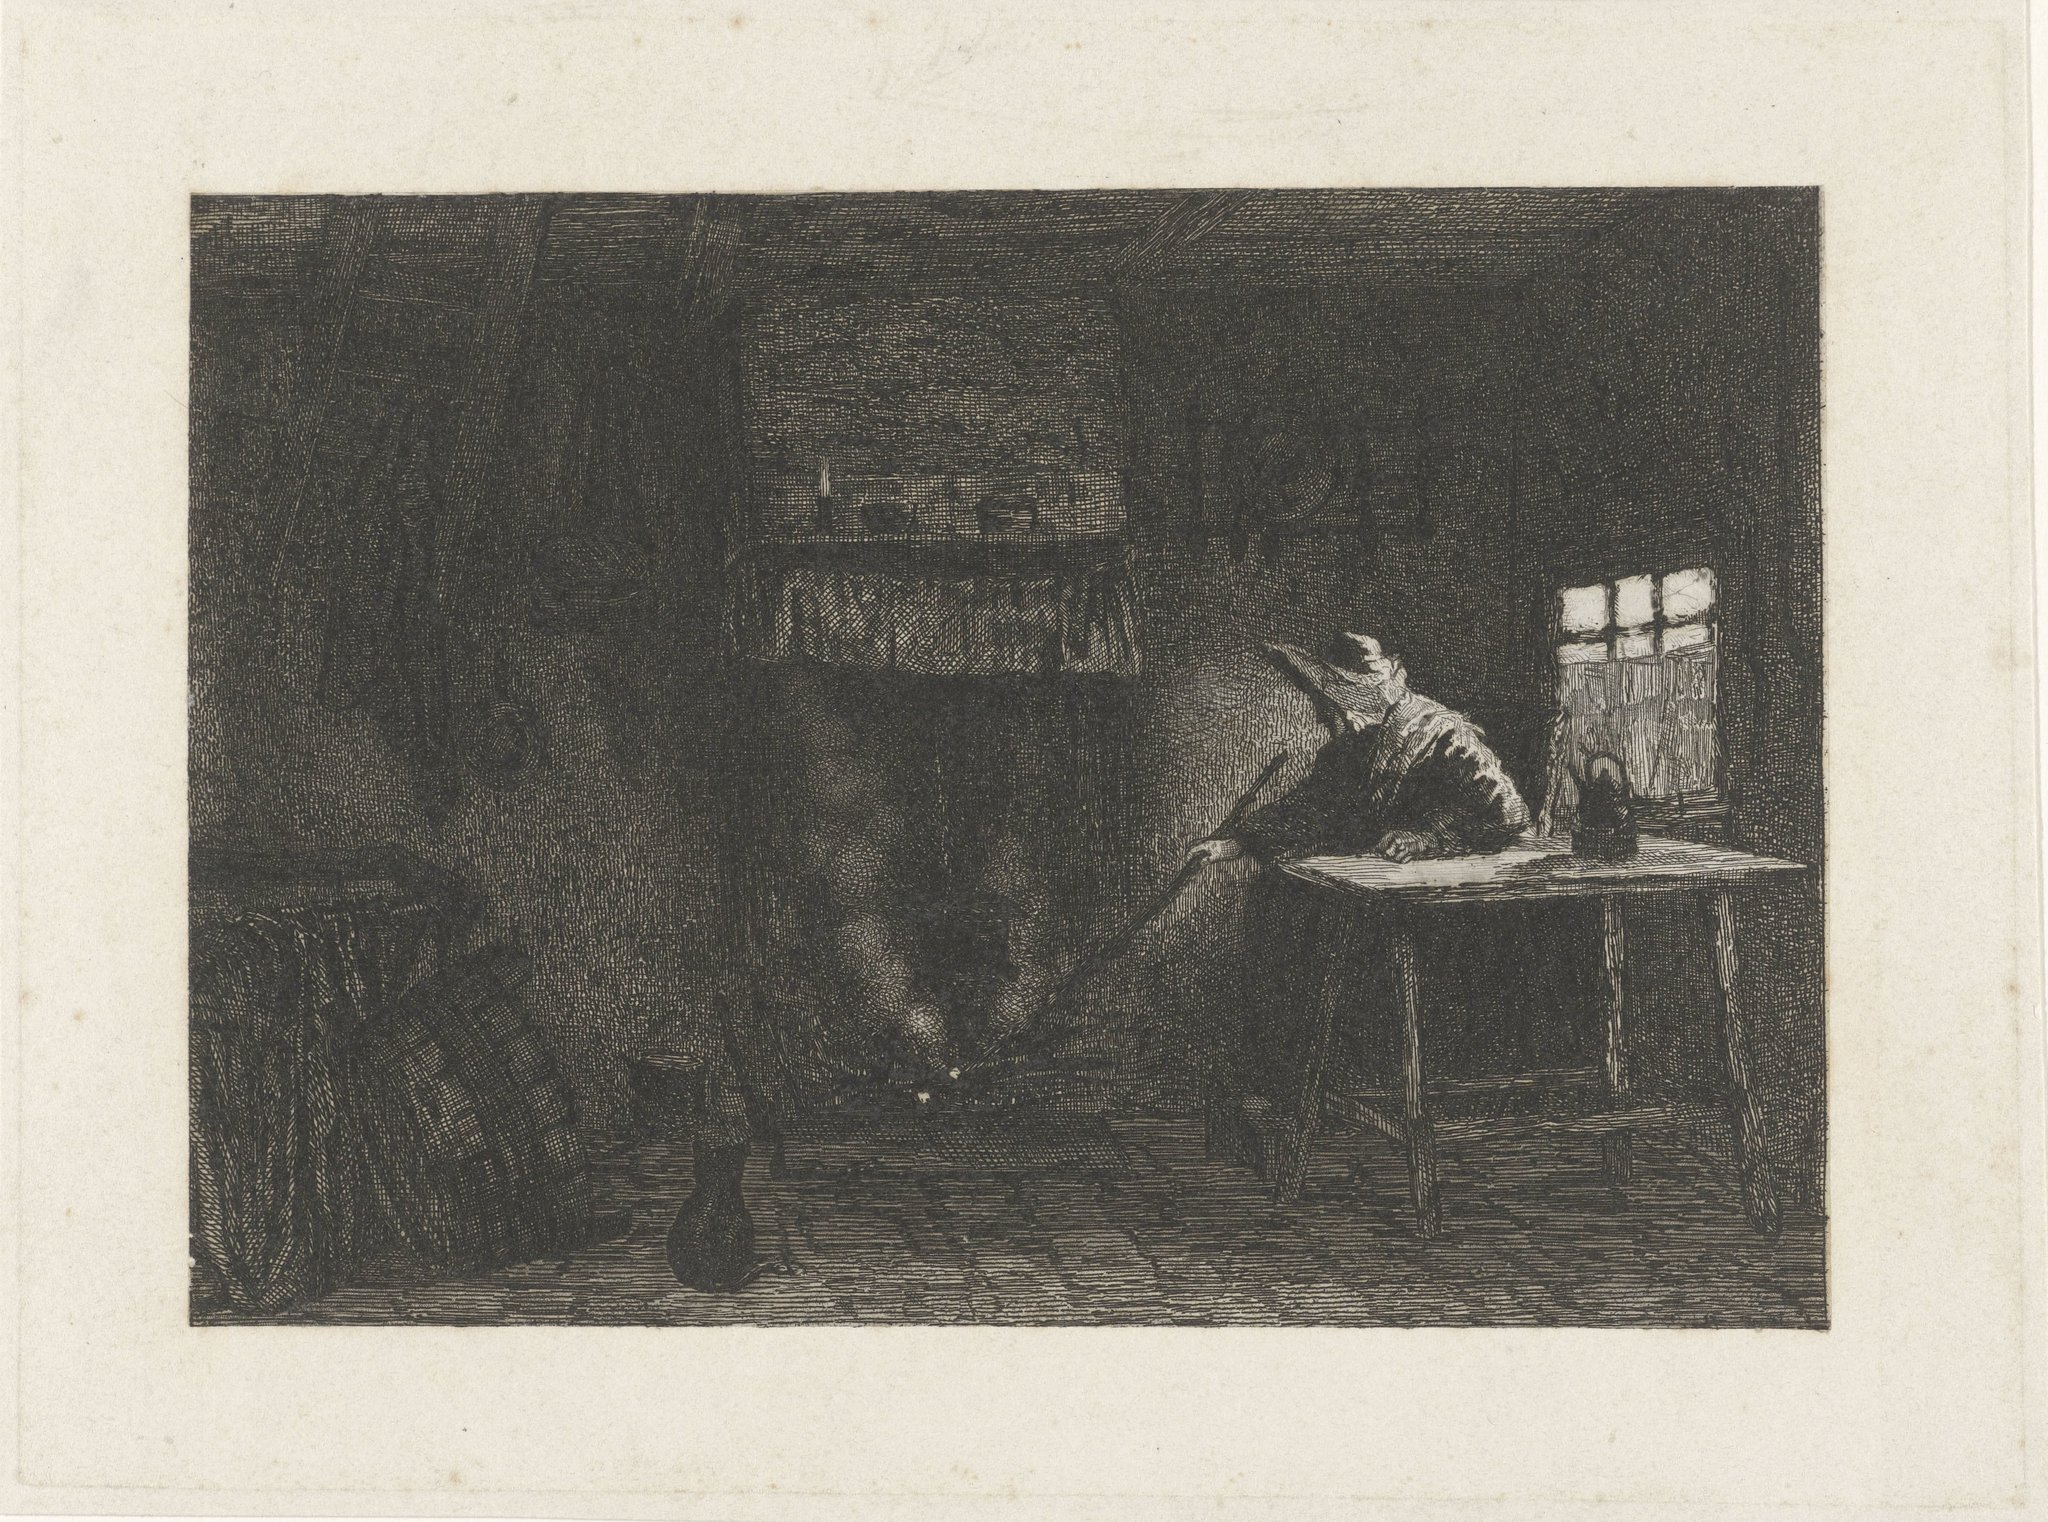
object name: print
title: Interieur met een vrouw bij de openhaard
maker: leopold löwenstam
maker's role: print maker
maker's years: 1842-1898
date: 1852-1898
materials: paper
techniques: etching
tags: open hearth, fire-place, interior of the house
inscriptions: collector's mark: Lugt 2228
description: Interieur met een vrouw die de openhaard opstookt.